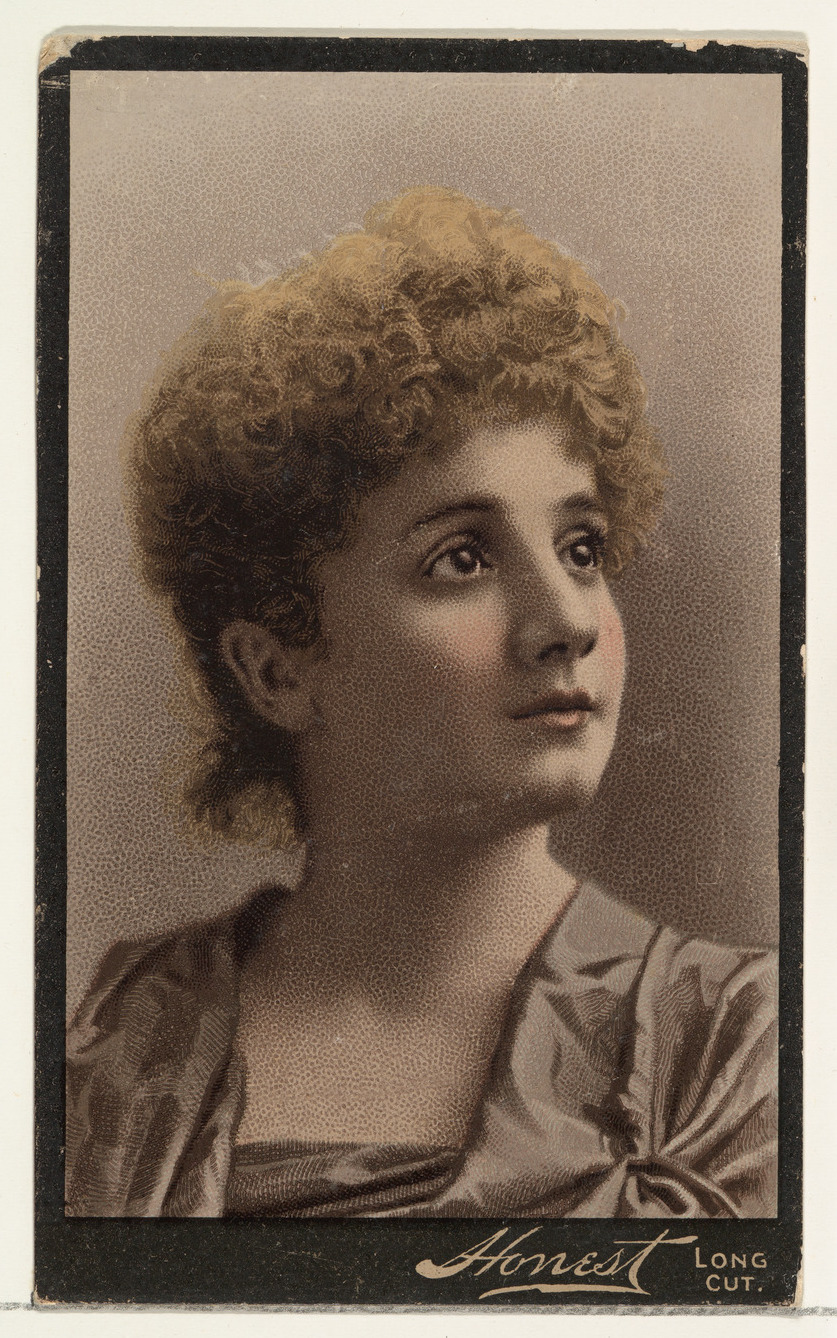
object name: print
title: Actress with short curly hair, from Stars of the Stage, Third Series (N131) issued by Duke Sons & Co. to promote Honest Long Cut Tobacco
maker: w. duke, sons & co.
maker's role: publisher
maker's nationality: american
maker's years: 1870-1920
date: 1891-1892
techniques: color lithograph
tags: portraits,women,actresses